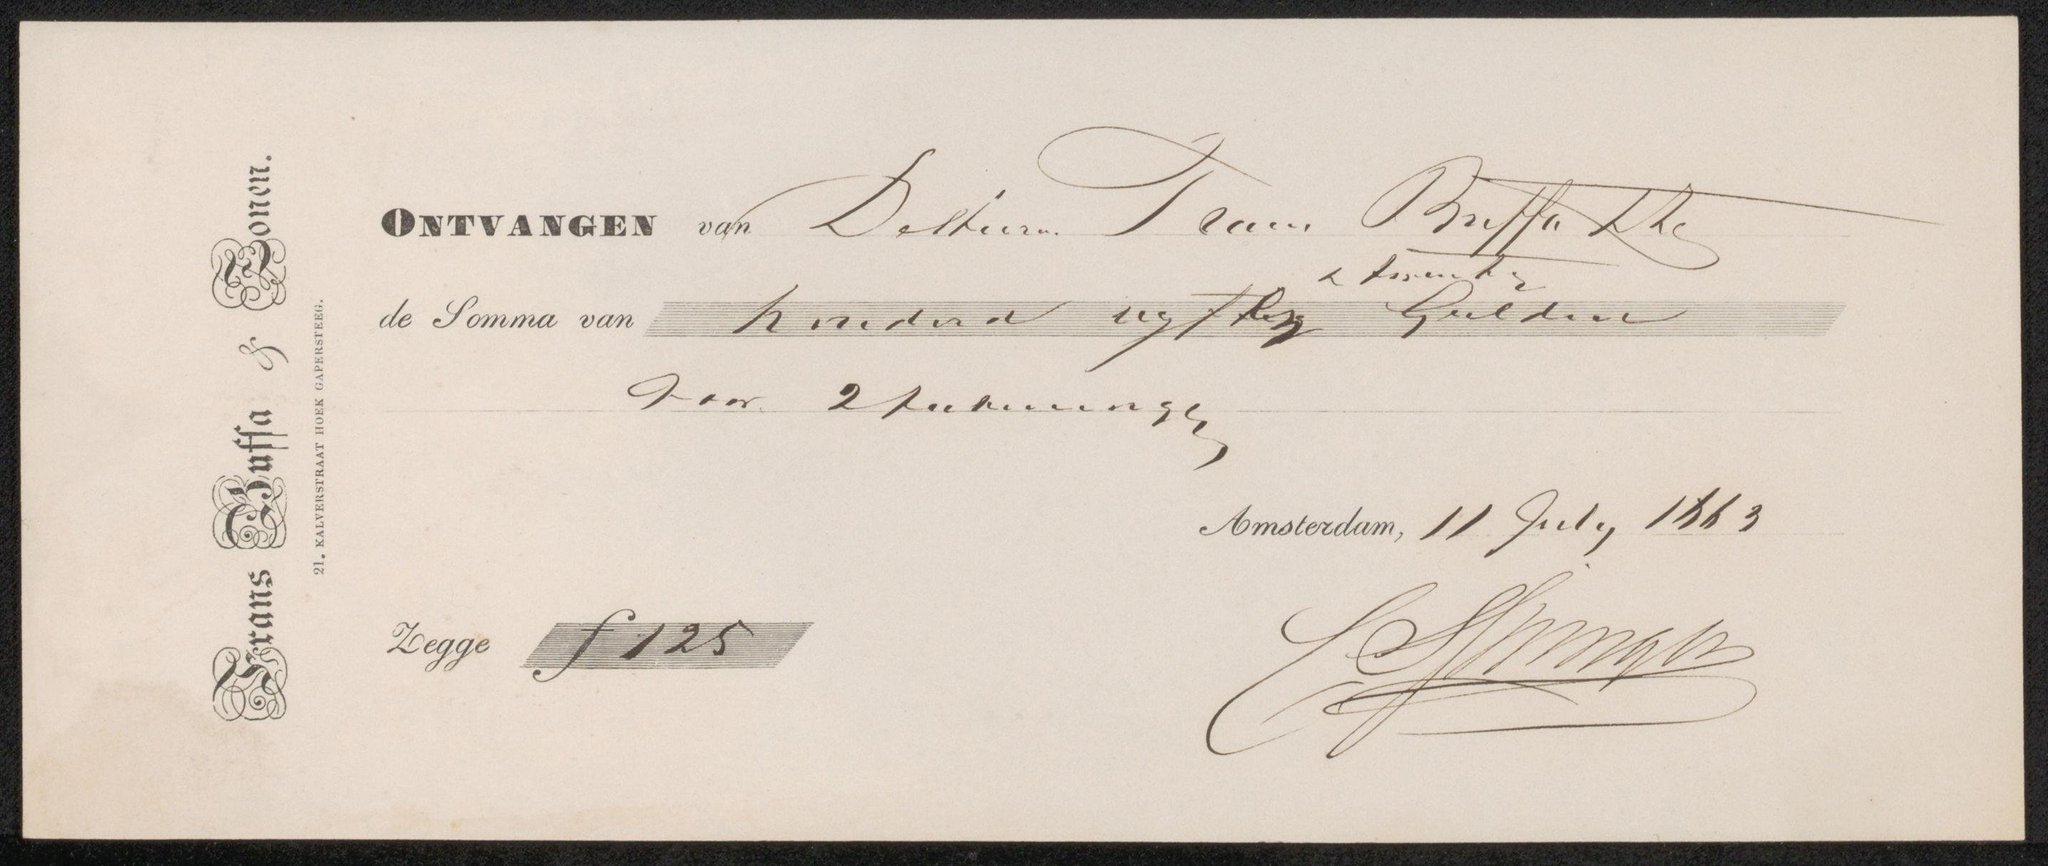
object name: ontvangstbewijs, kwitantie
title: Kwitantie voor Cornelis Springer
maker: cornelis springer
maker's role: draughtsman, painter, print maker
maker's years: 1817-1891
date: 1863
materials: ink, paper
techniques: pen, printing, writing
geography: amsterdam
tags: drawing, money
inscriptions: collector's mark: Lugt 2233